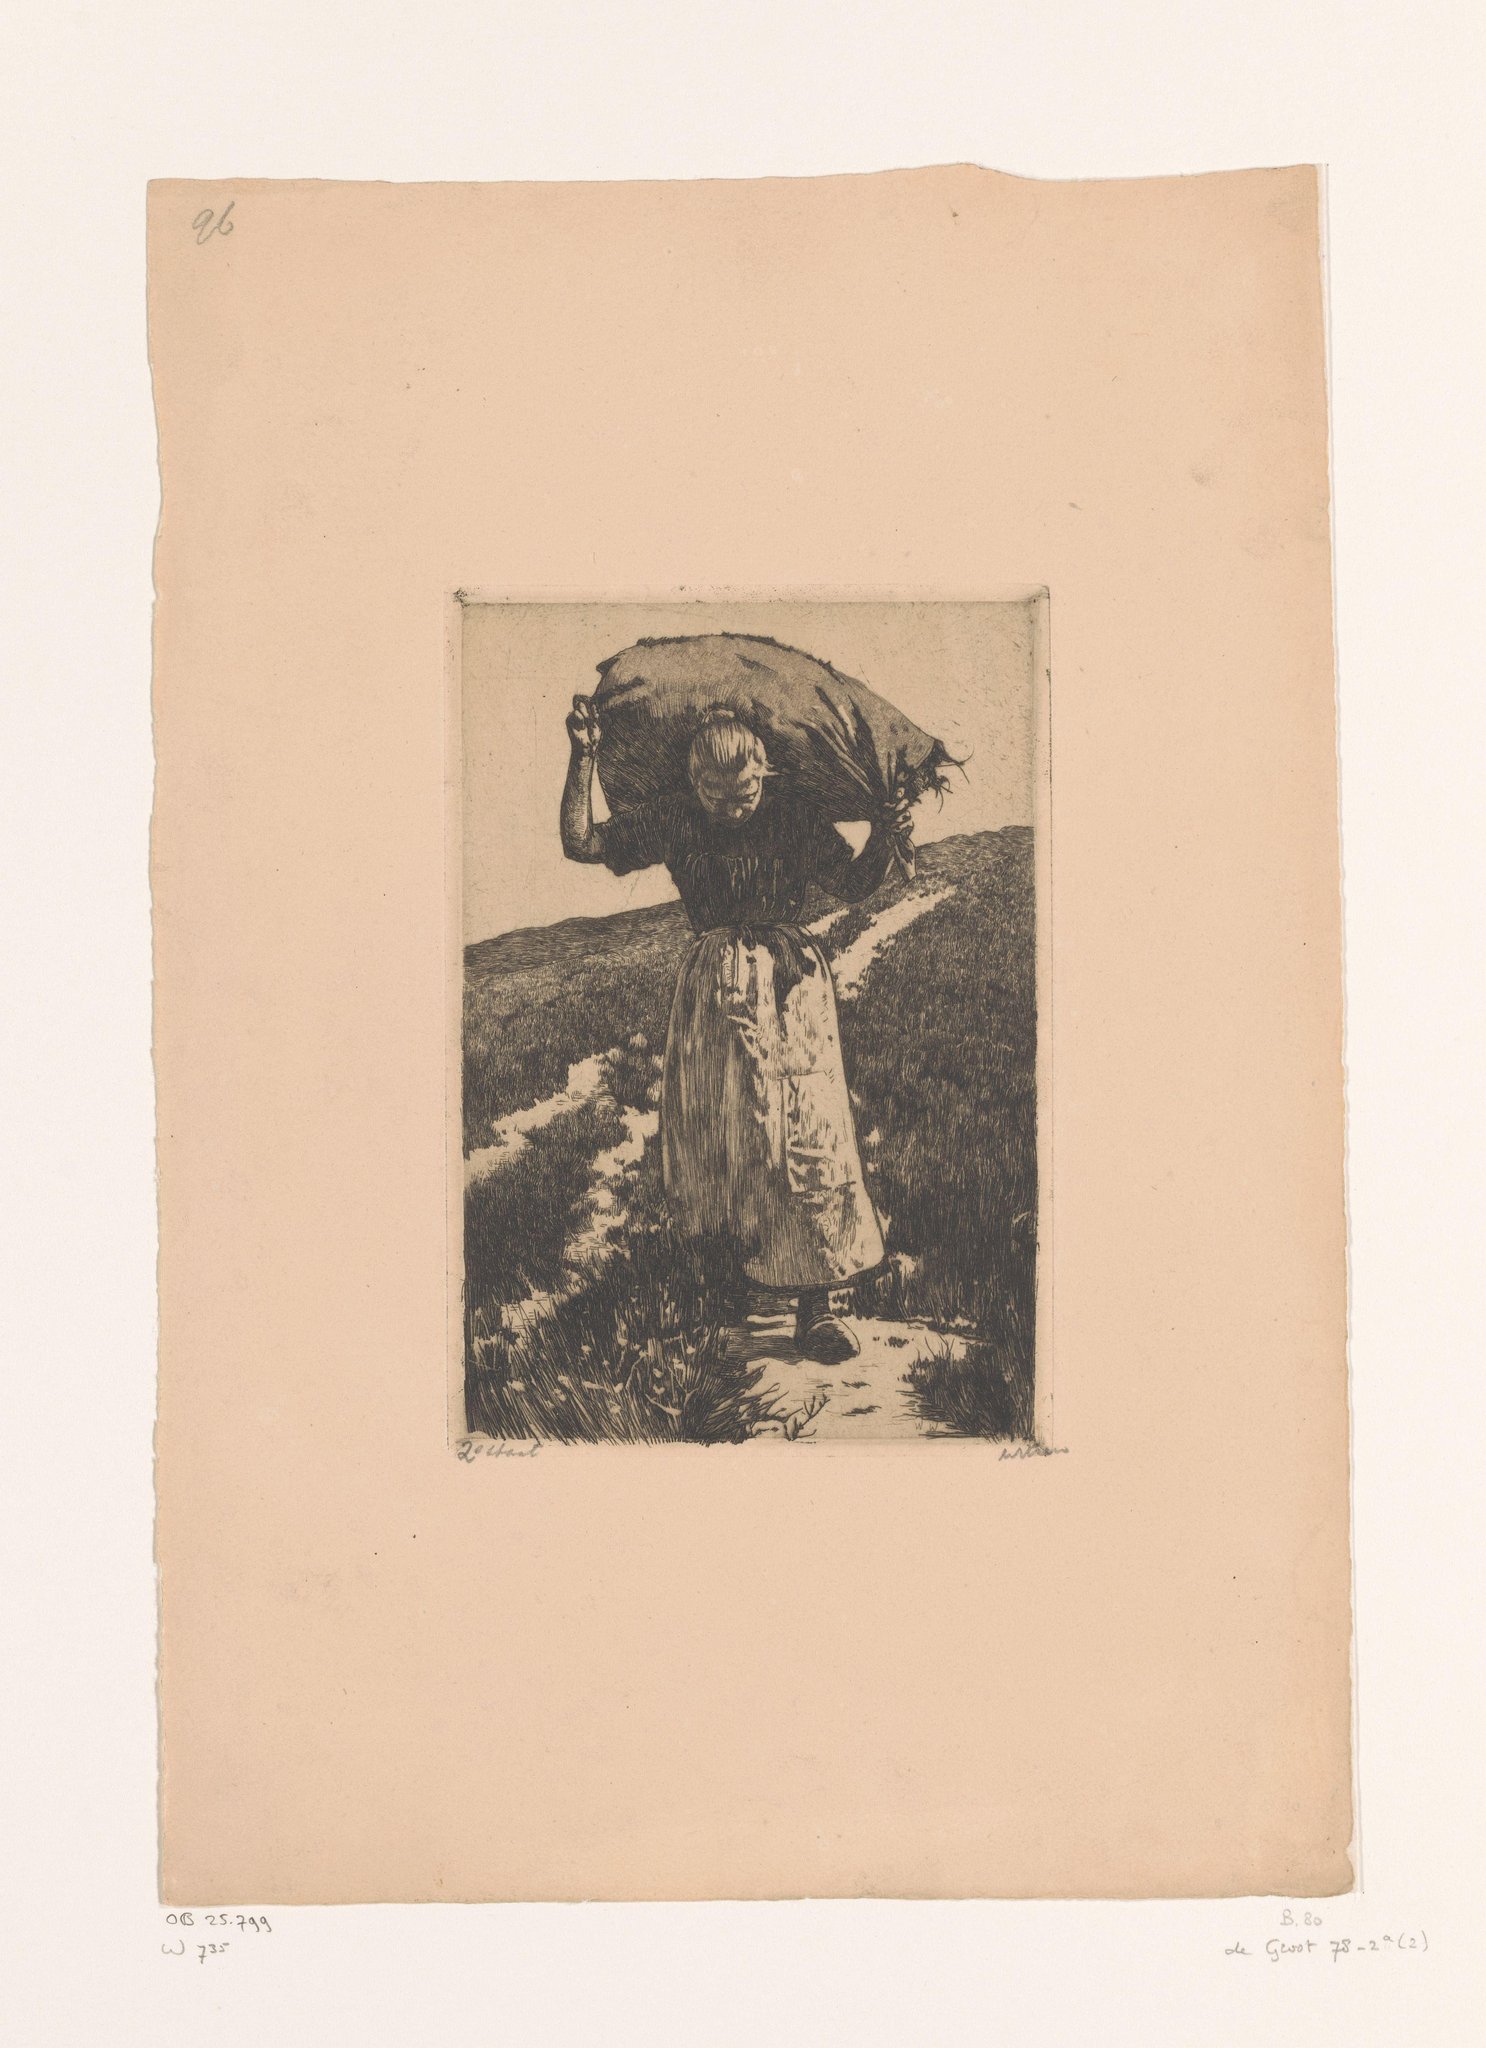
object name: print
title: Op de heide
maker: willem witsen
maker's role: draughtsman, painter, print maker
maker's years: 1860-1923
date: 1897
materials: paper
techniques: aquatint, etching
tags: farmers - aa - female farmer, farmer's wife, storing in sacks ~ harvest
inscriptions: annotation: ‘2e staat’